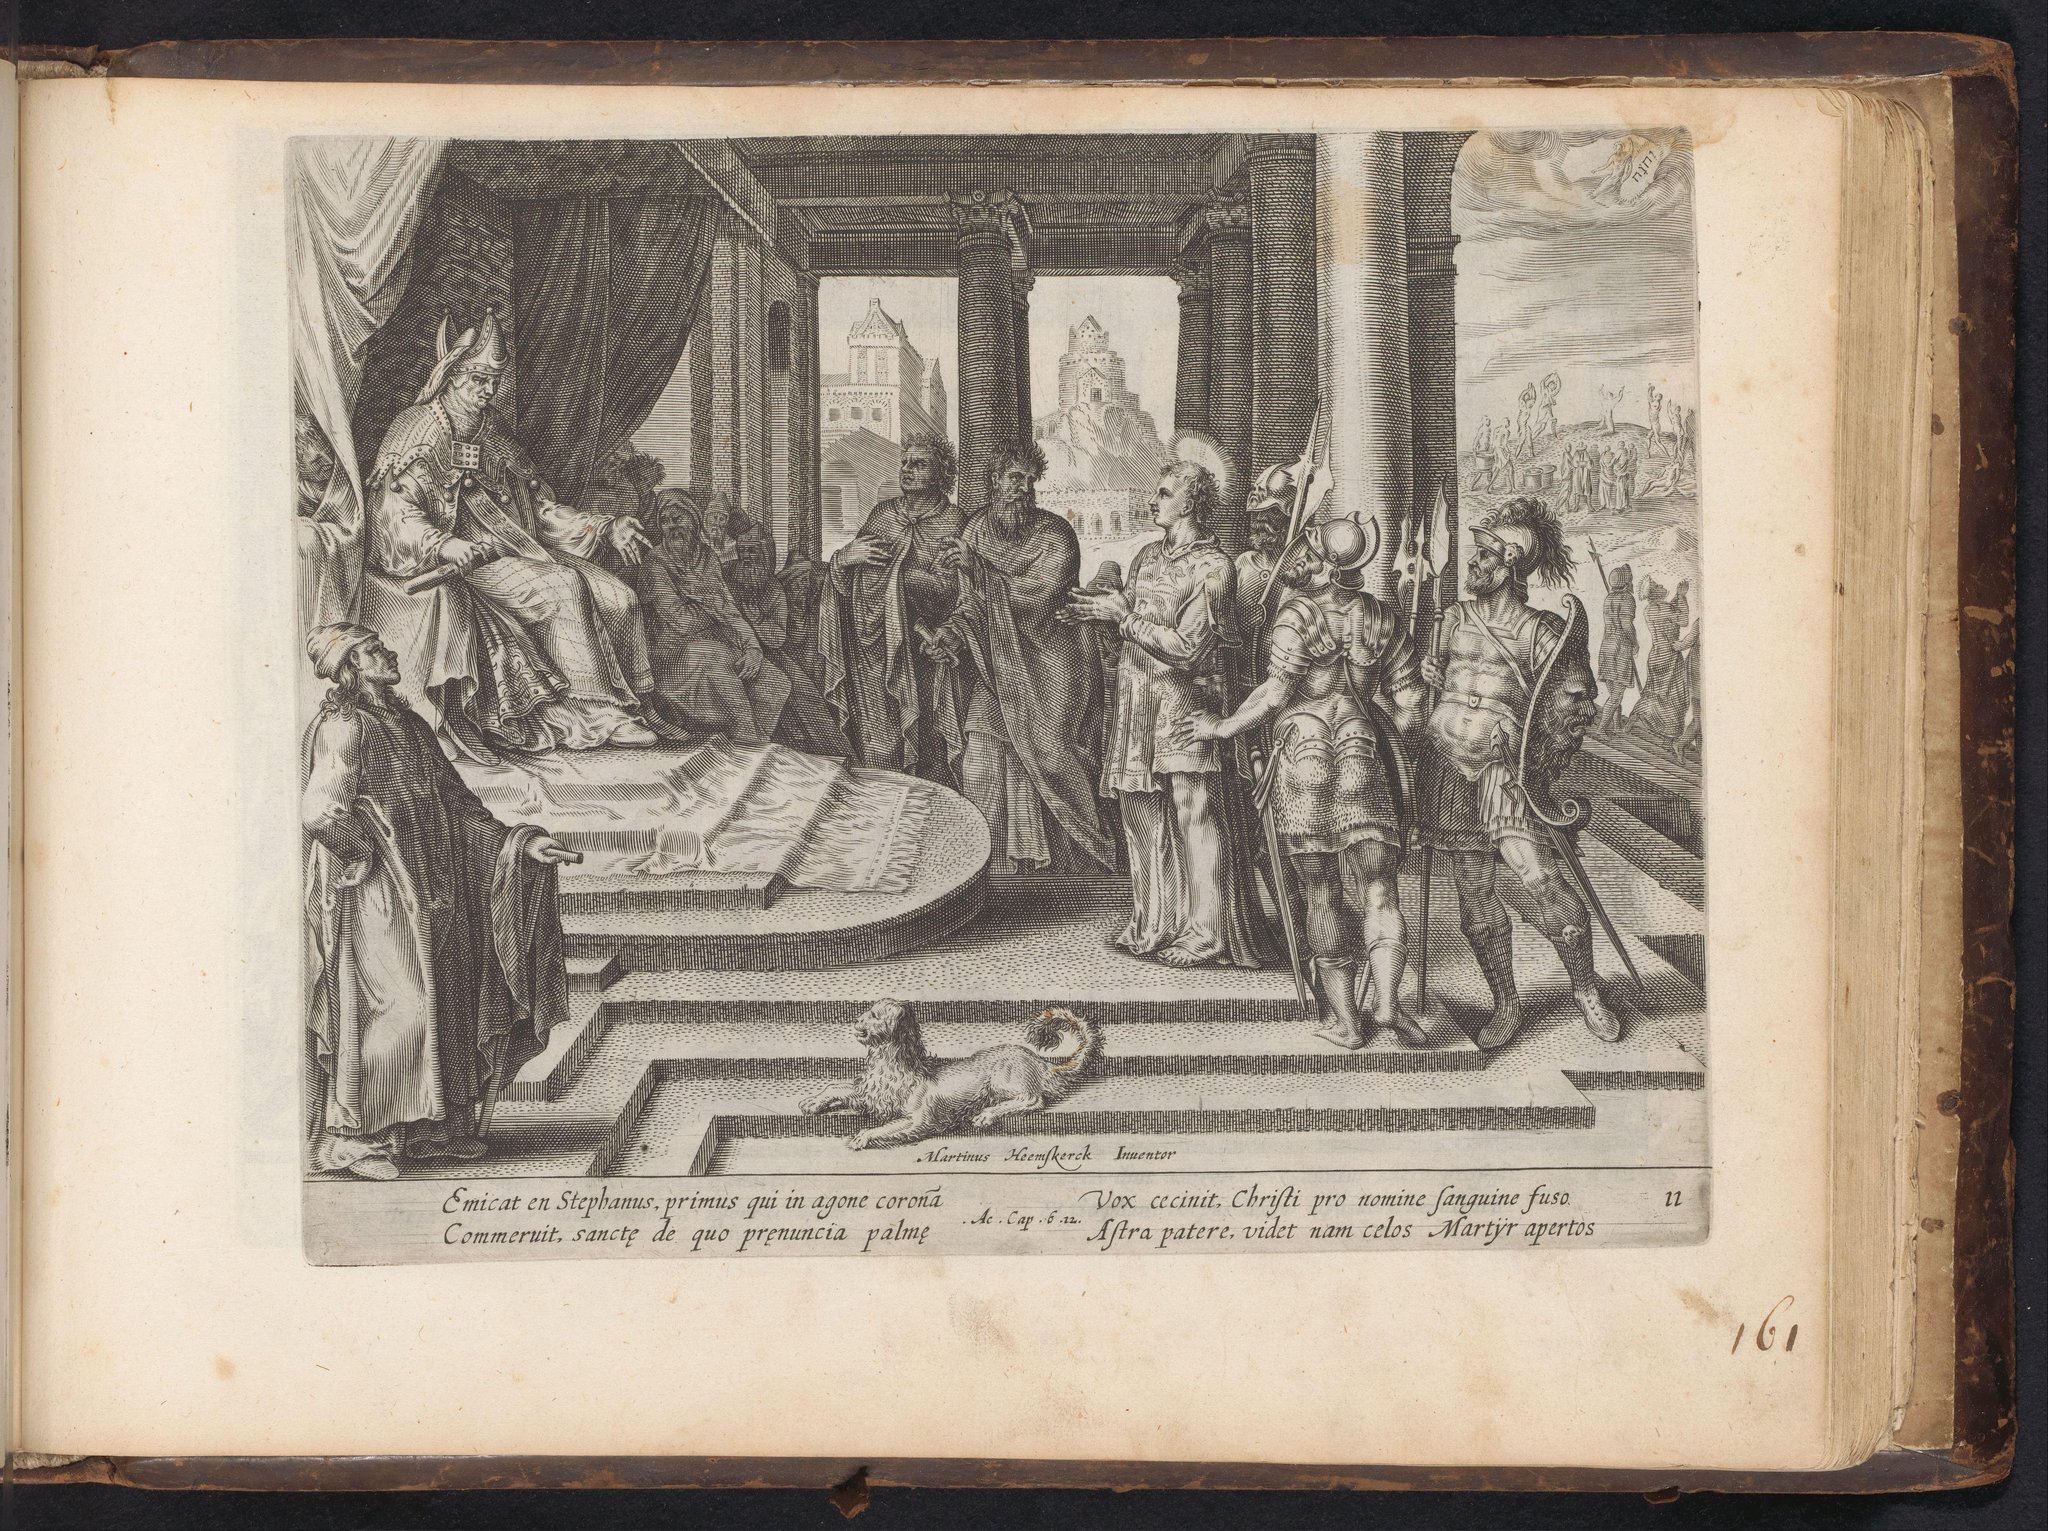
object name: album leaf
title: Stefanus voor de hogepriester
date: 1643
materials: paper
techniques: engraving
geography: alkmaar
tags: the stoning of stephen; the witnesses lay down their clothes at saul's feet, tetragram (in roman or hebrew script) ~ symbol of god the father (+ christ), stephen before the sanhedrin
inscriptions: number: ‘161’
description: Stefanus wordt voor de hogepriester geleid. Daarna wordt Stefanus weggeleid en in de achtergrond door de Joden gestenigd. Boven in de wolken het visioen van Christus en God de Vader. Onder de voorstelling een verwijzing in het Latijn naar de Bijbeltekst in Hand. 6:12. Deze prent maakt deel uit van een album.